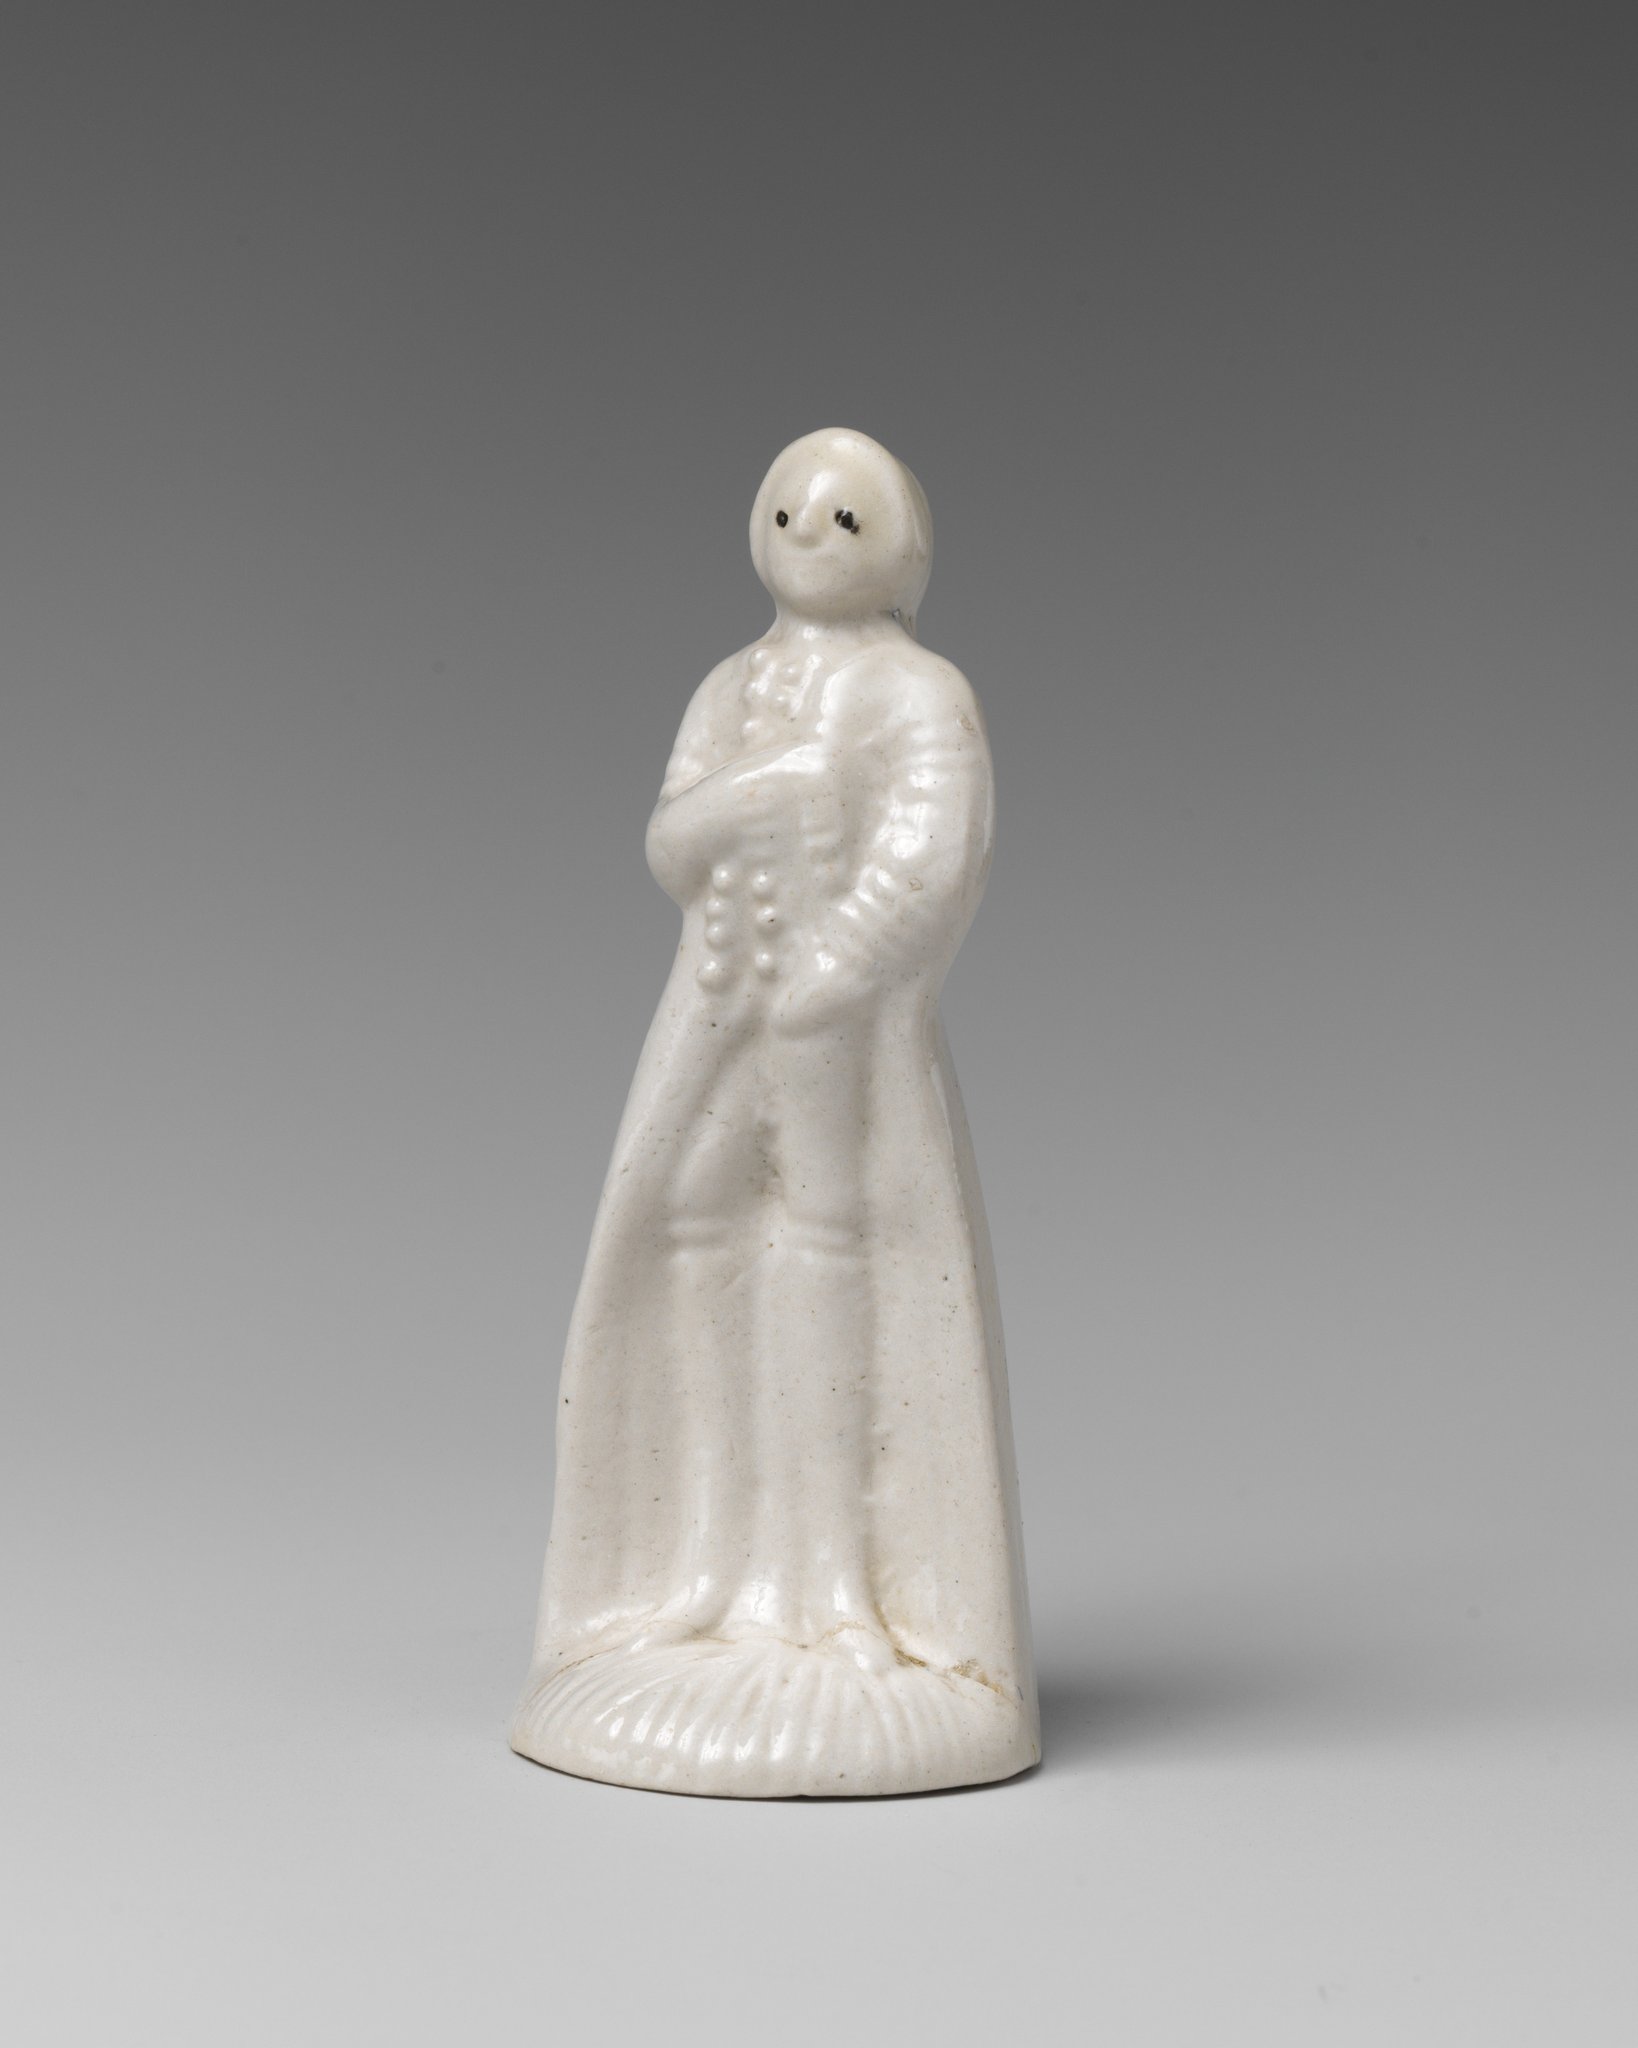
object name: figure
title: Figure of a man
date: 1745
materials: stoneware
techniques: salt glaze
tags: men